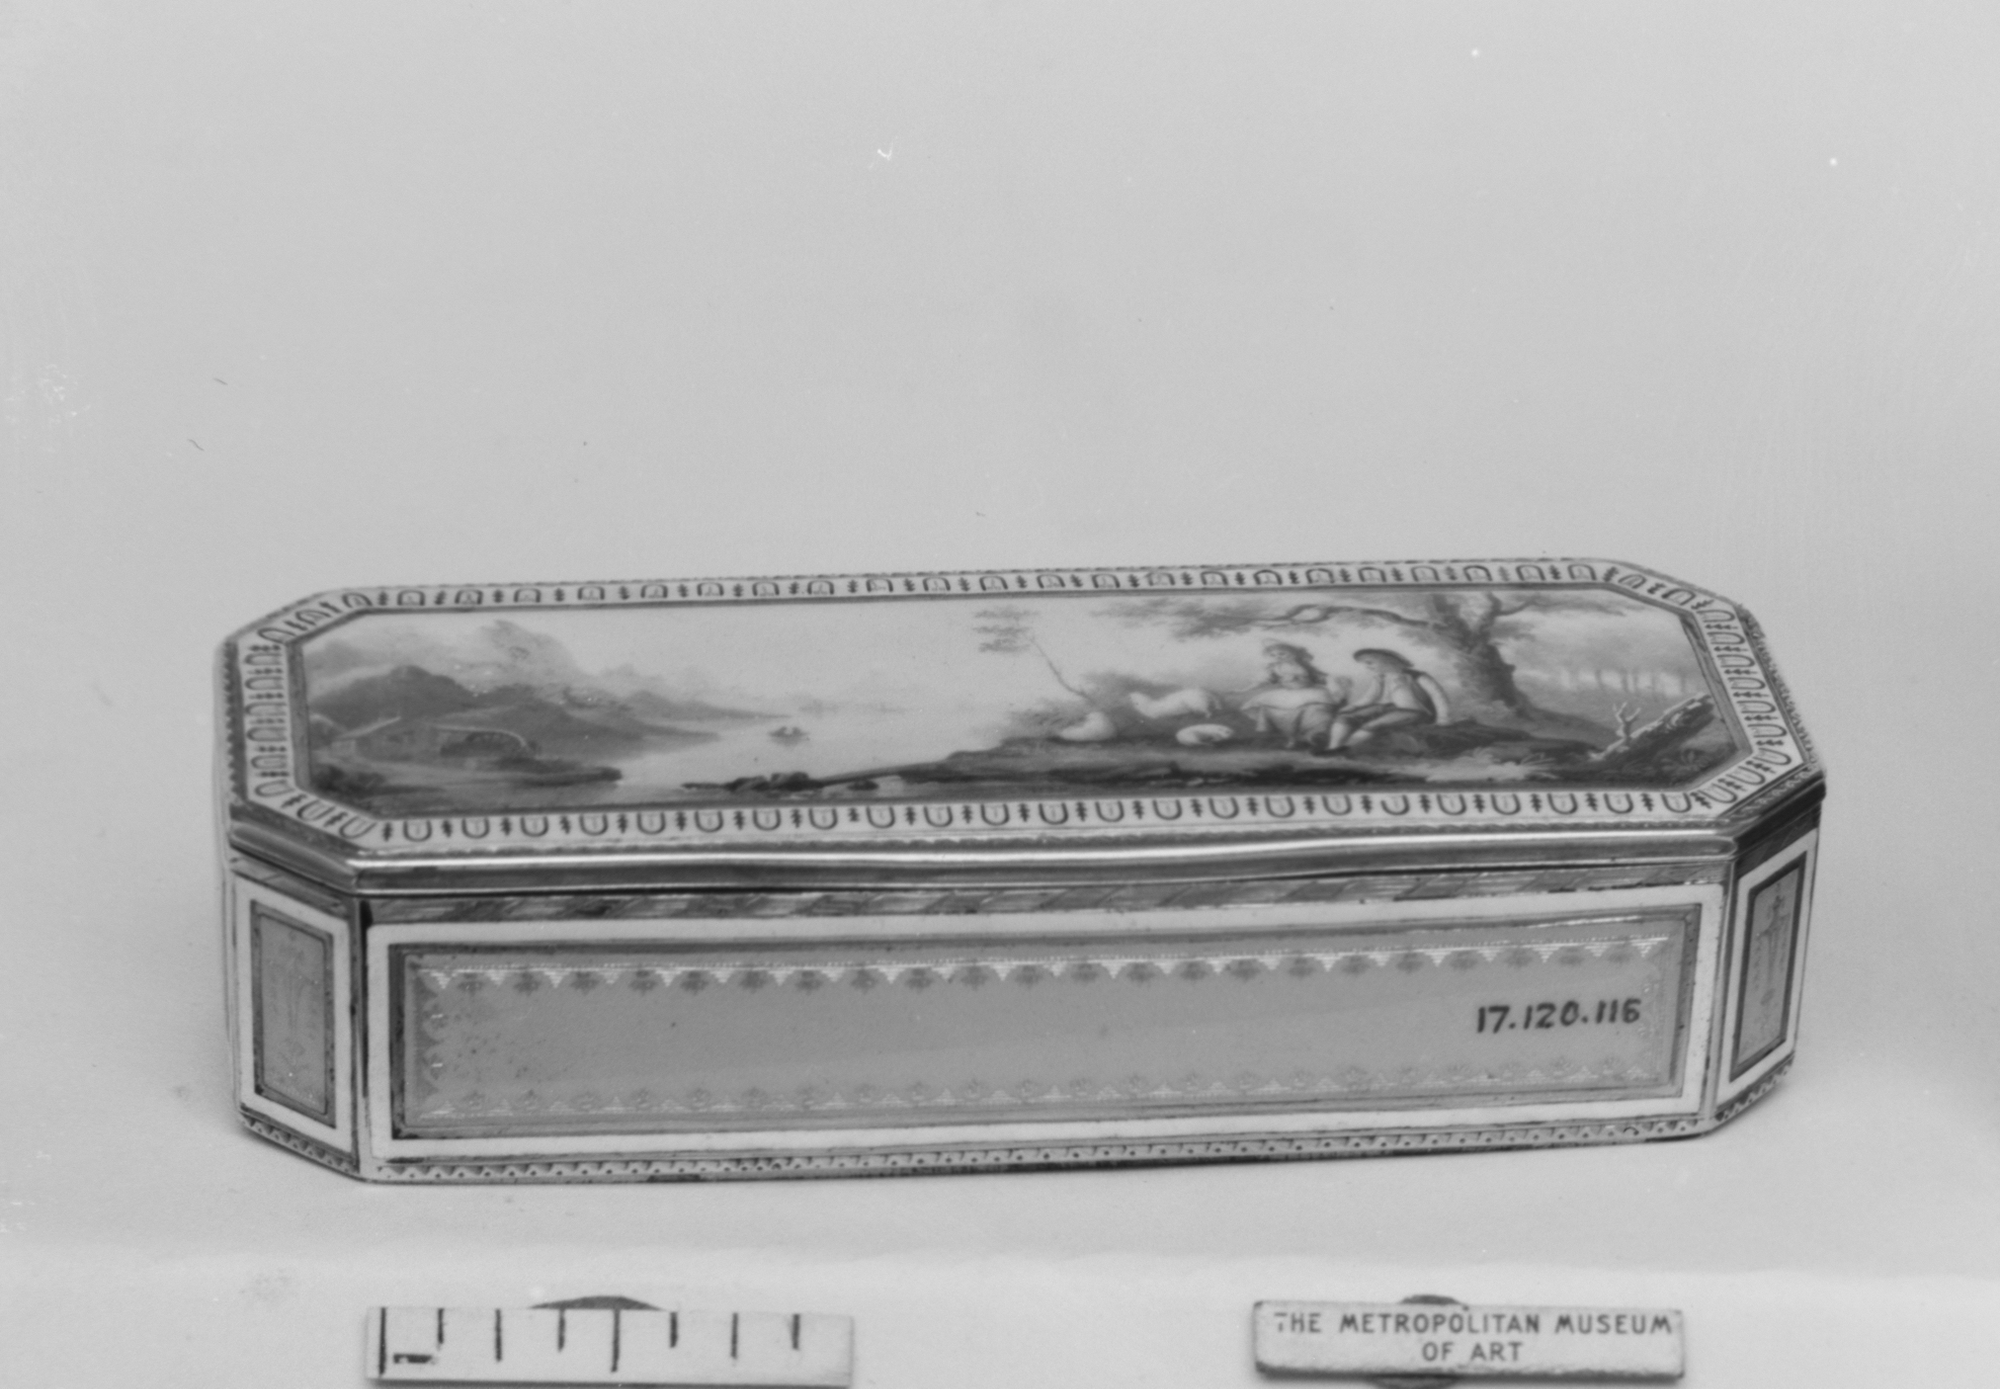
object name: snuffbox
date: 1801-1825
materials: enamel, gold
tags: human figures,trees